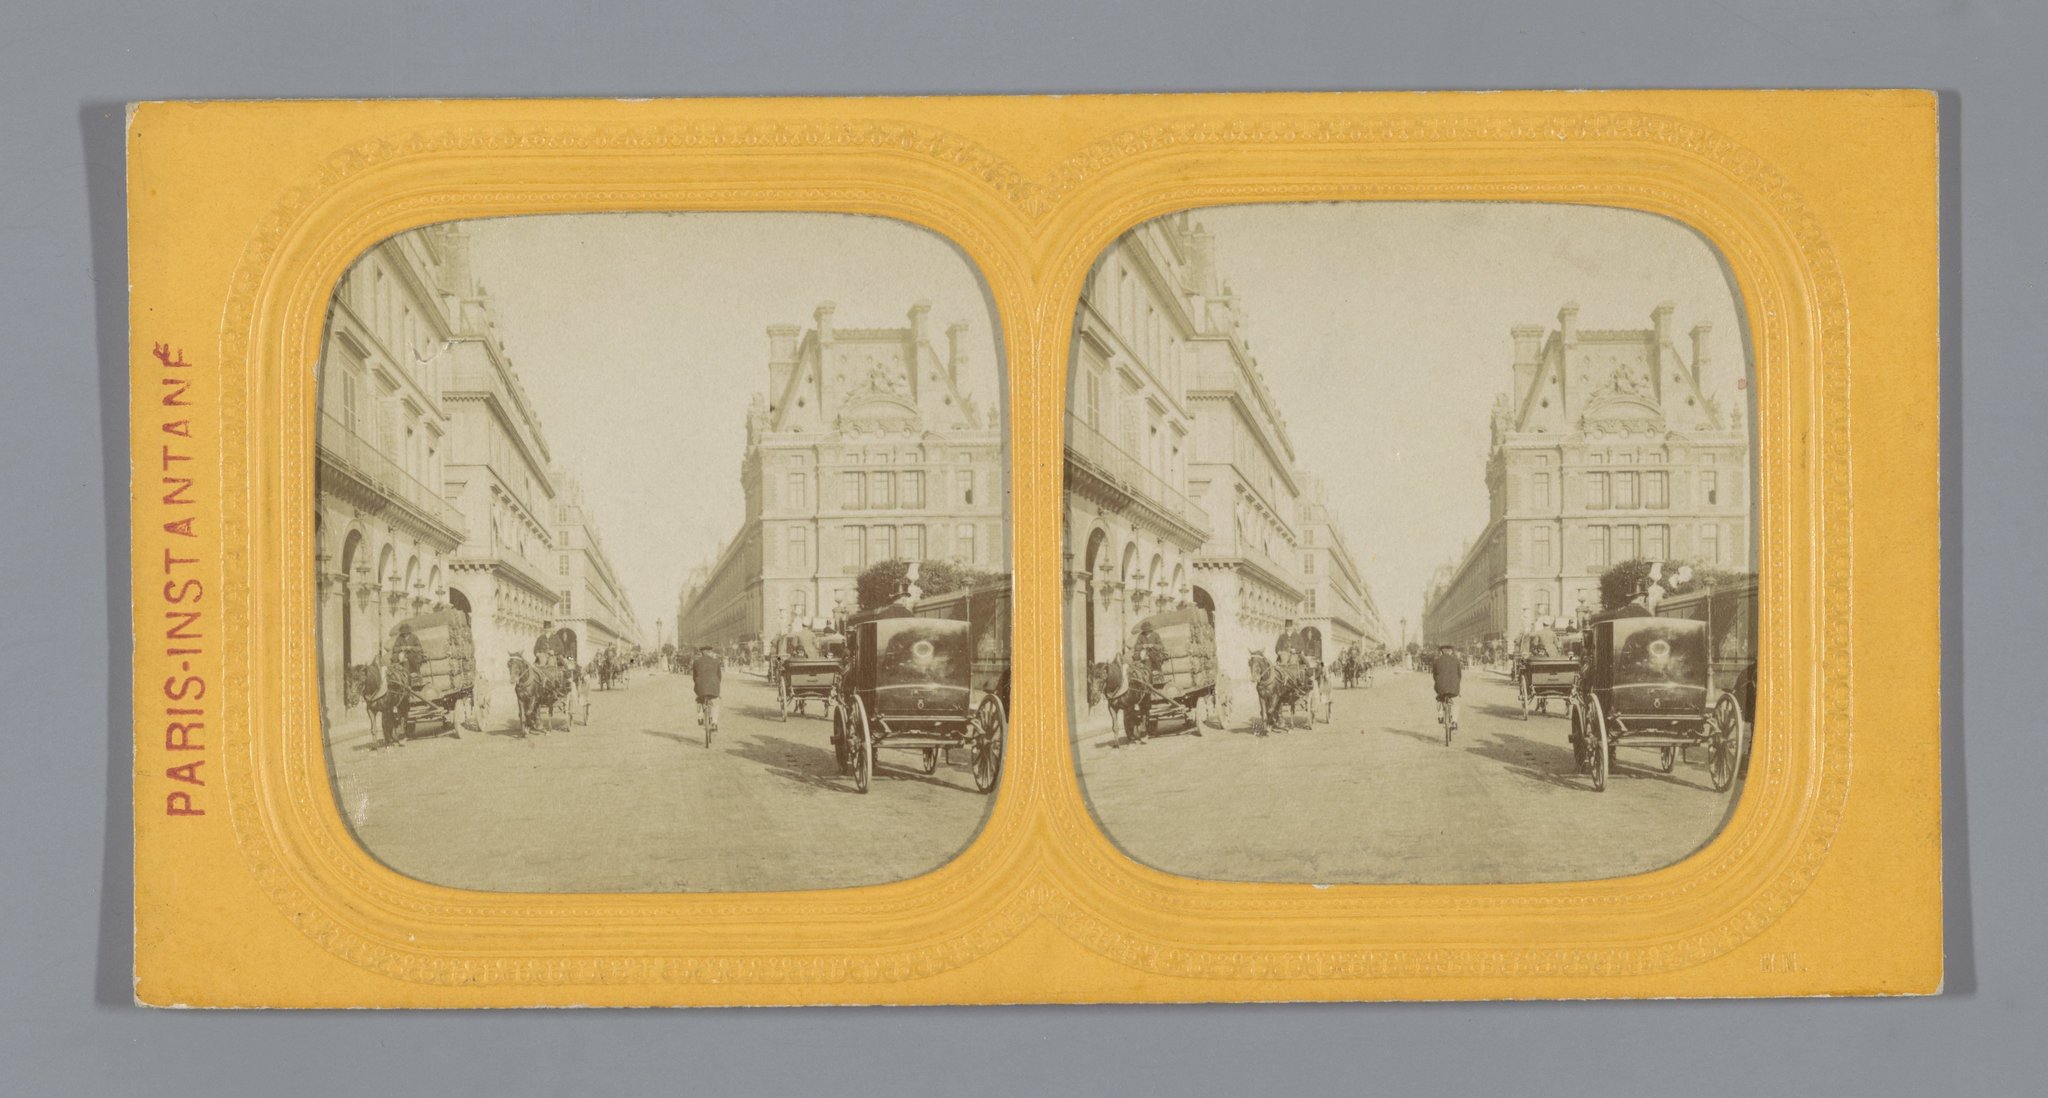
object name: tissue stereograph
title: Paris-Instantané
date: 1855-1875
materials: cardboard, paper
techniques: albumen print, hand coloring, perforating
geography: paris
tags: four-wheeled vehicle drawn by one animal, façade (of house or building), street, tuileries palace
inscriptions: monogram: ‘H.N.’